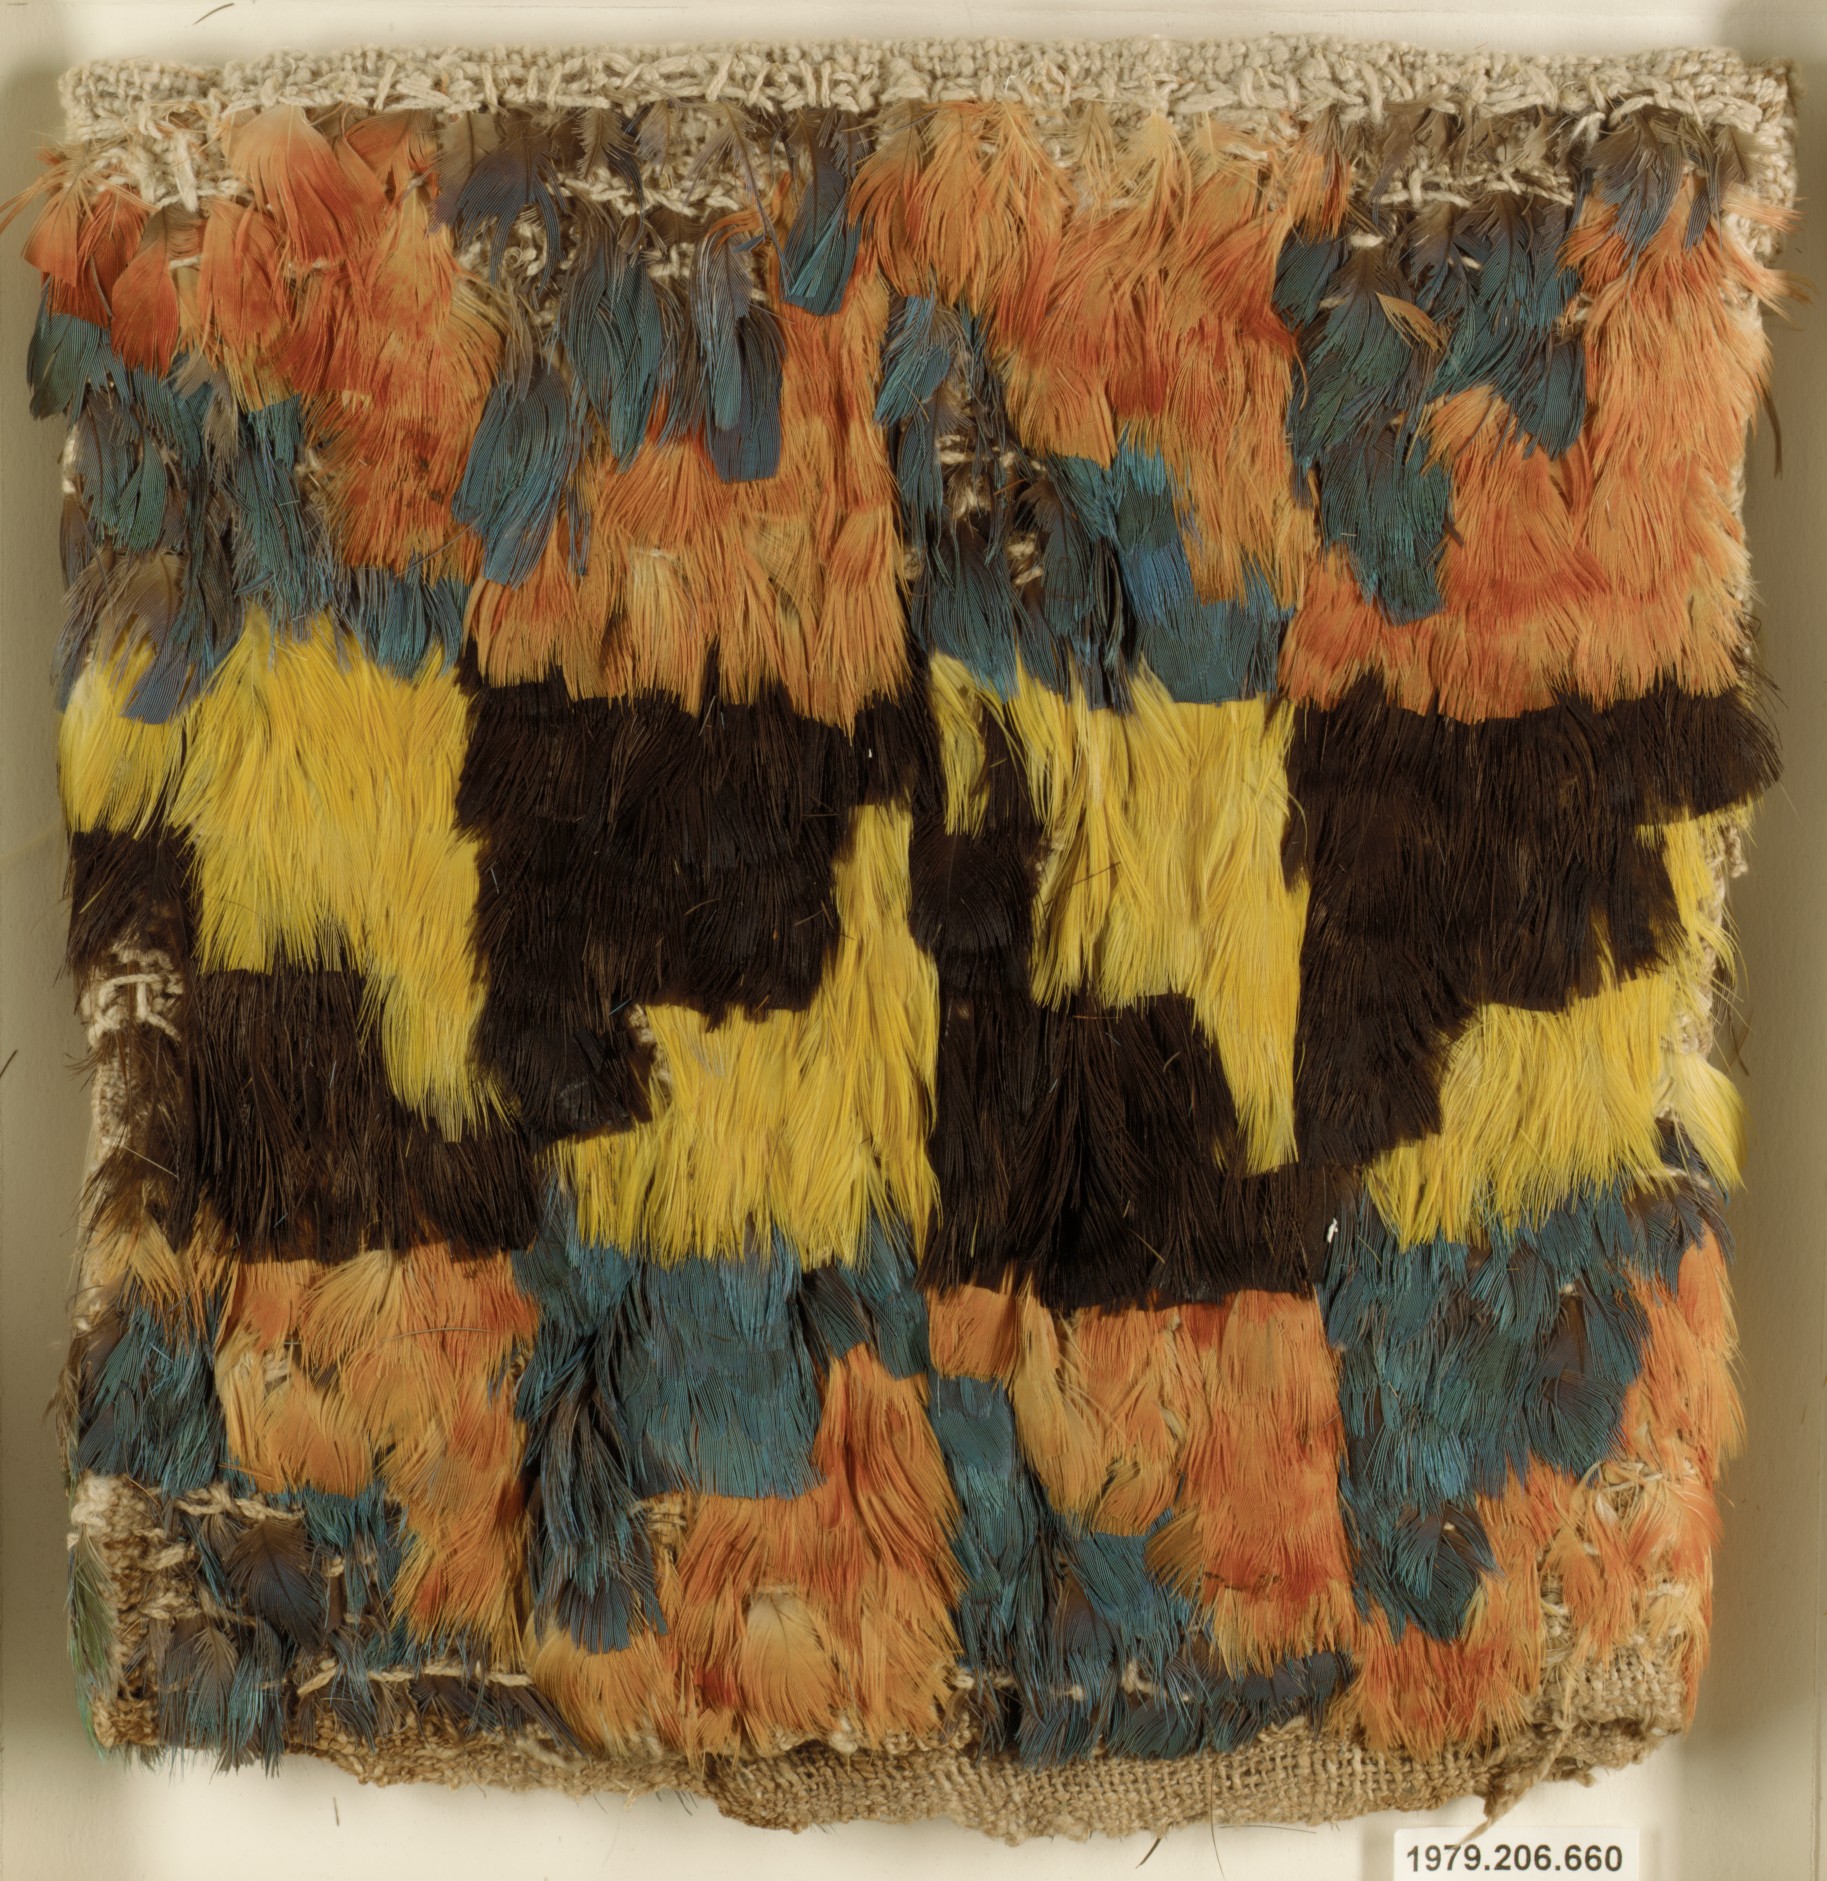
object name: miniature dress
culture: ica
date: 1101-1300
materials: cotton, feather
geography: peru